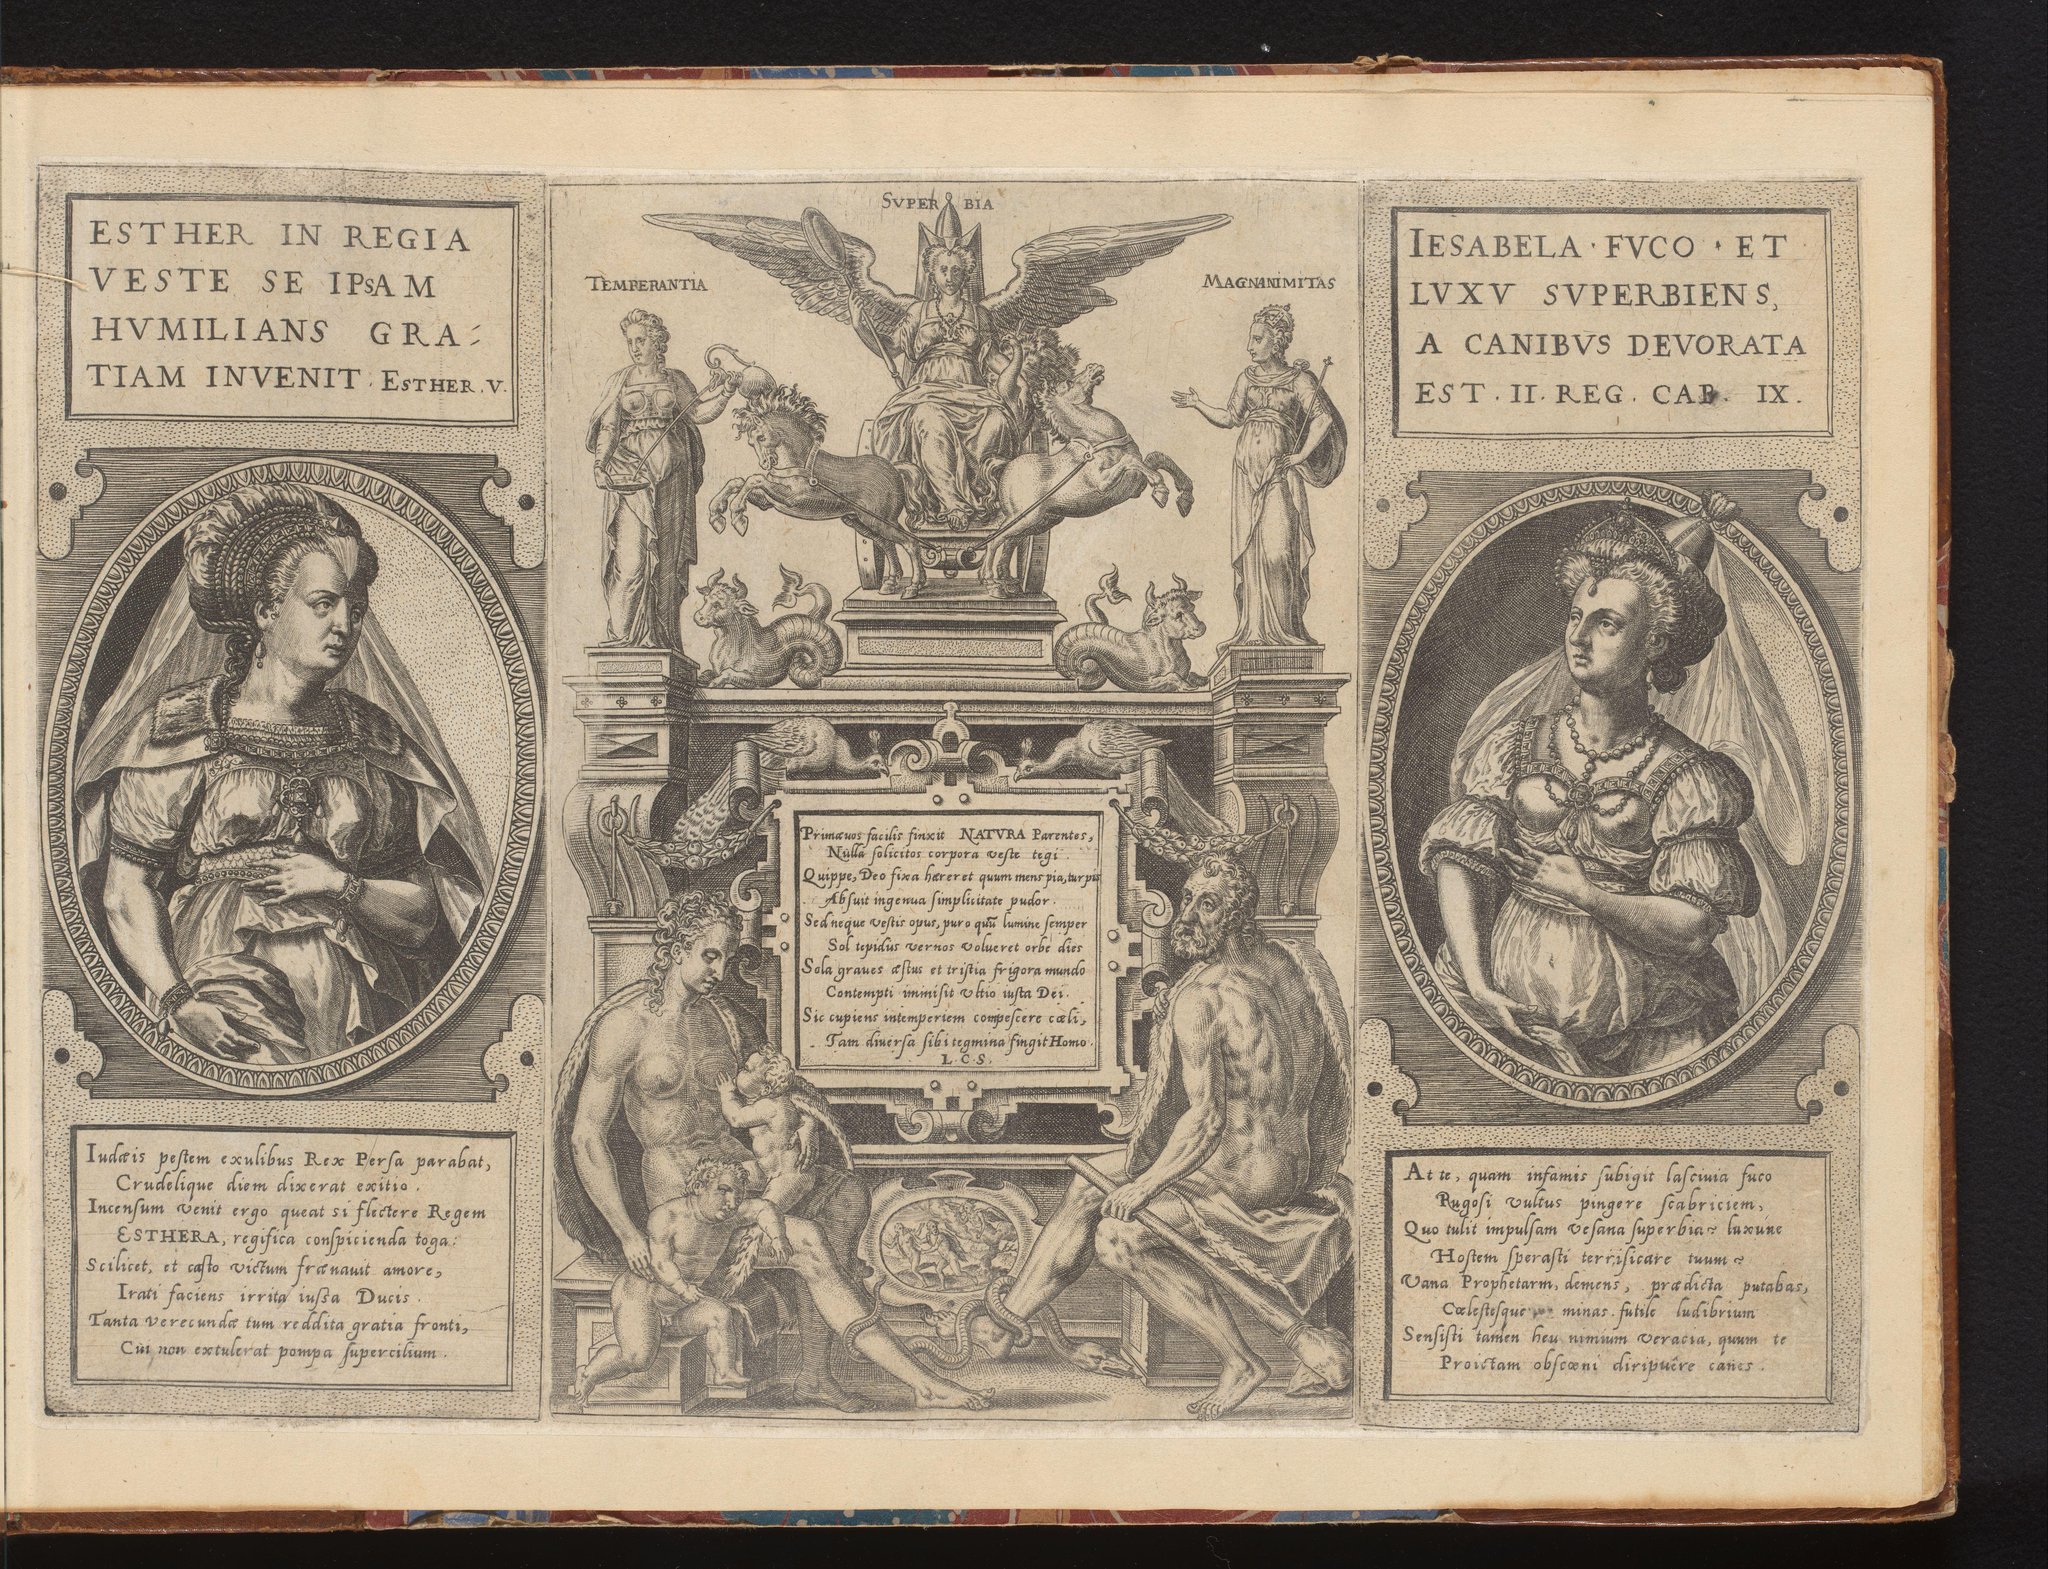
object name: album leaf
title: Adam en Eva in allegorische setting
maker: abraham de bruyn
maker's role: print maker, publisher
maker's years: 1540-1587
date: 1581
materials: paper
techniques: engraving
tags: the labours of adam and eve; infancy of cain and abel (genesis 4:1-2)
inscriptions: date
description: Tekst in cartouche met signatuur L.C.S. Middenonder de naakte Adam en Eva met Esau en Jacob. Prent uit het boek 'Omnium pene Europae, Asiae, Aphricae atque Americae gentium habitus...', 1581. De prent maakt deel uit van een album.